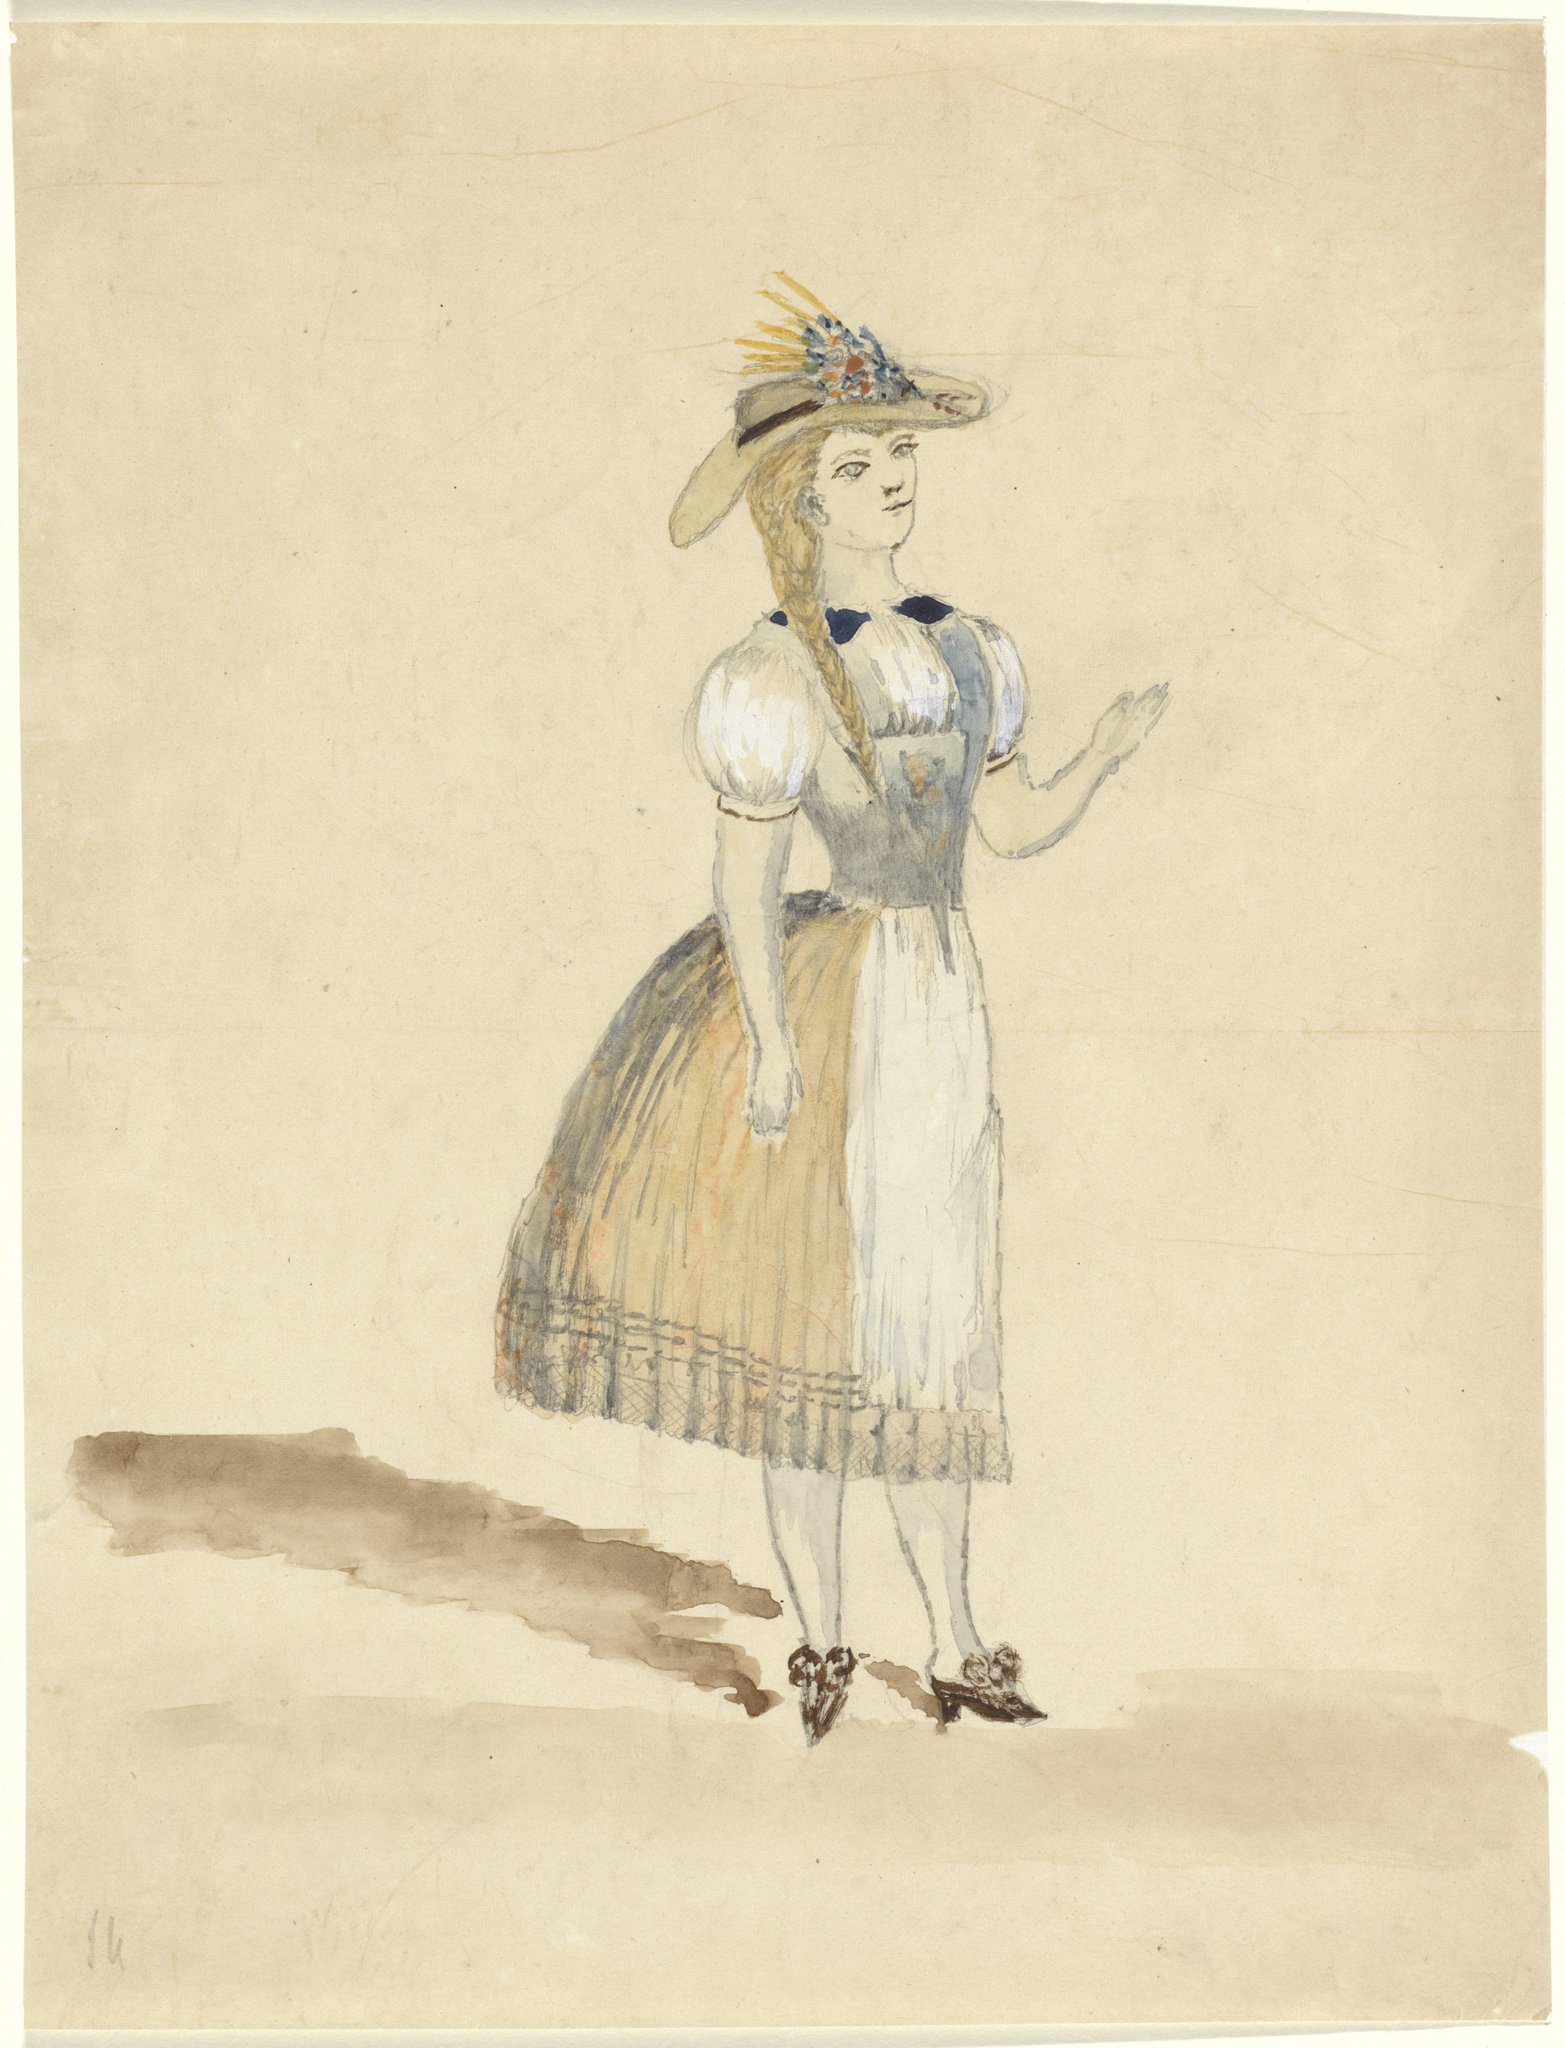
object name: watercolor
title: Staand meisje in klederdracht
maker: pieter van loon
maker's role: draughtsman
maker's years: 1801-1873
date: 1811-1873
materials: paper, pencil, watercolor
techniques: brush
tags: folk costume, regional costume